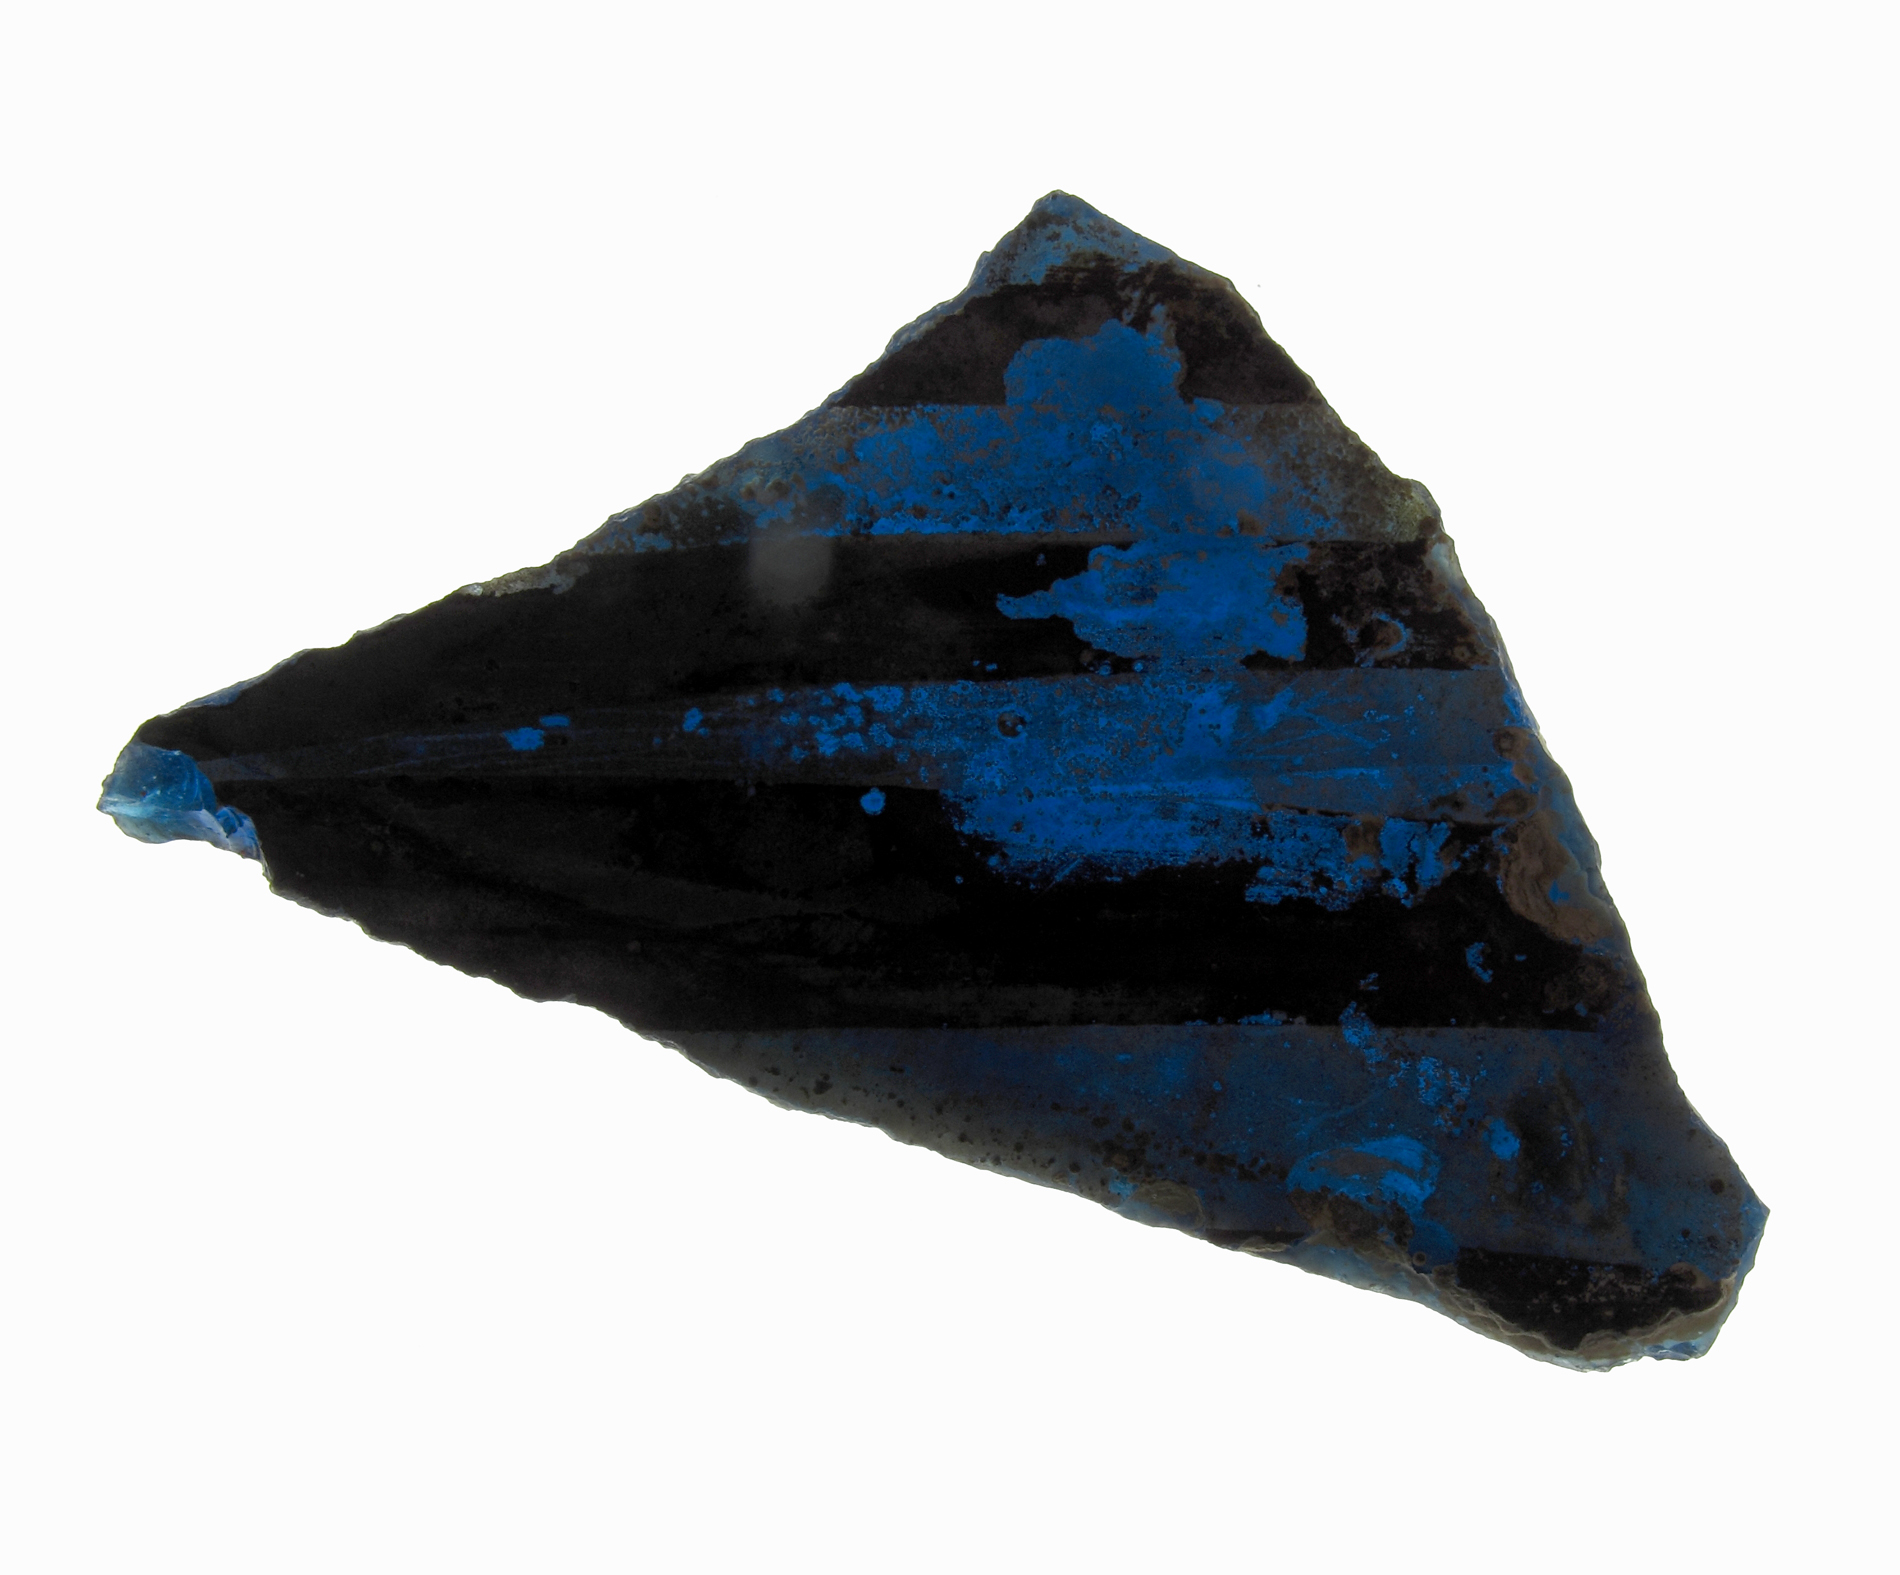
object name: fragment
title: Glass Fragment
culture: european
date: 1201-1400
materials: glass, metal